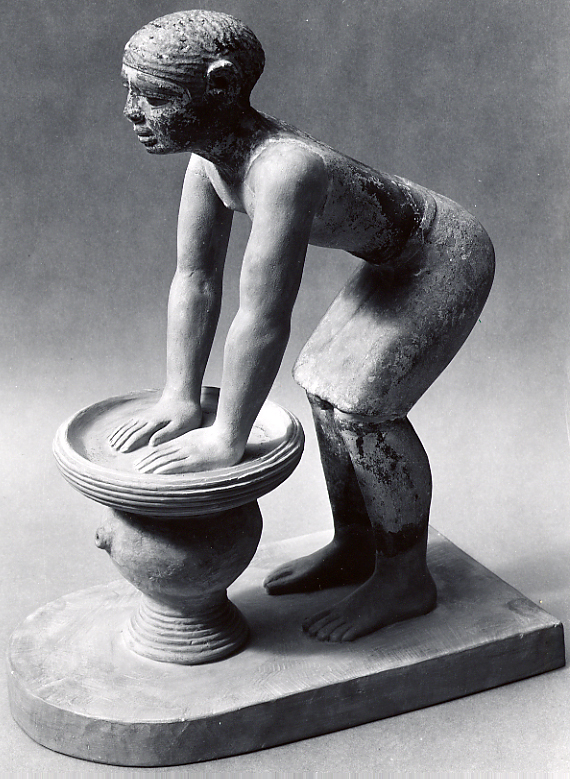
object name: statuette, male beer maker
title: Figure of a male beer-maker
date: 2649-2100 BCE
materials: limestone, paint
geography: egypt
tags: men,working